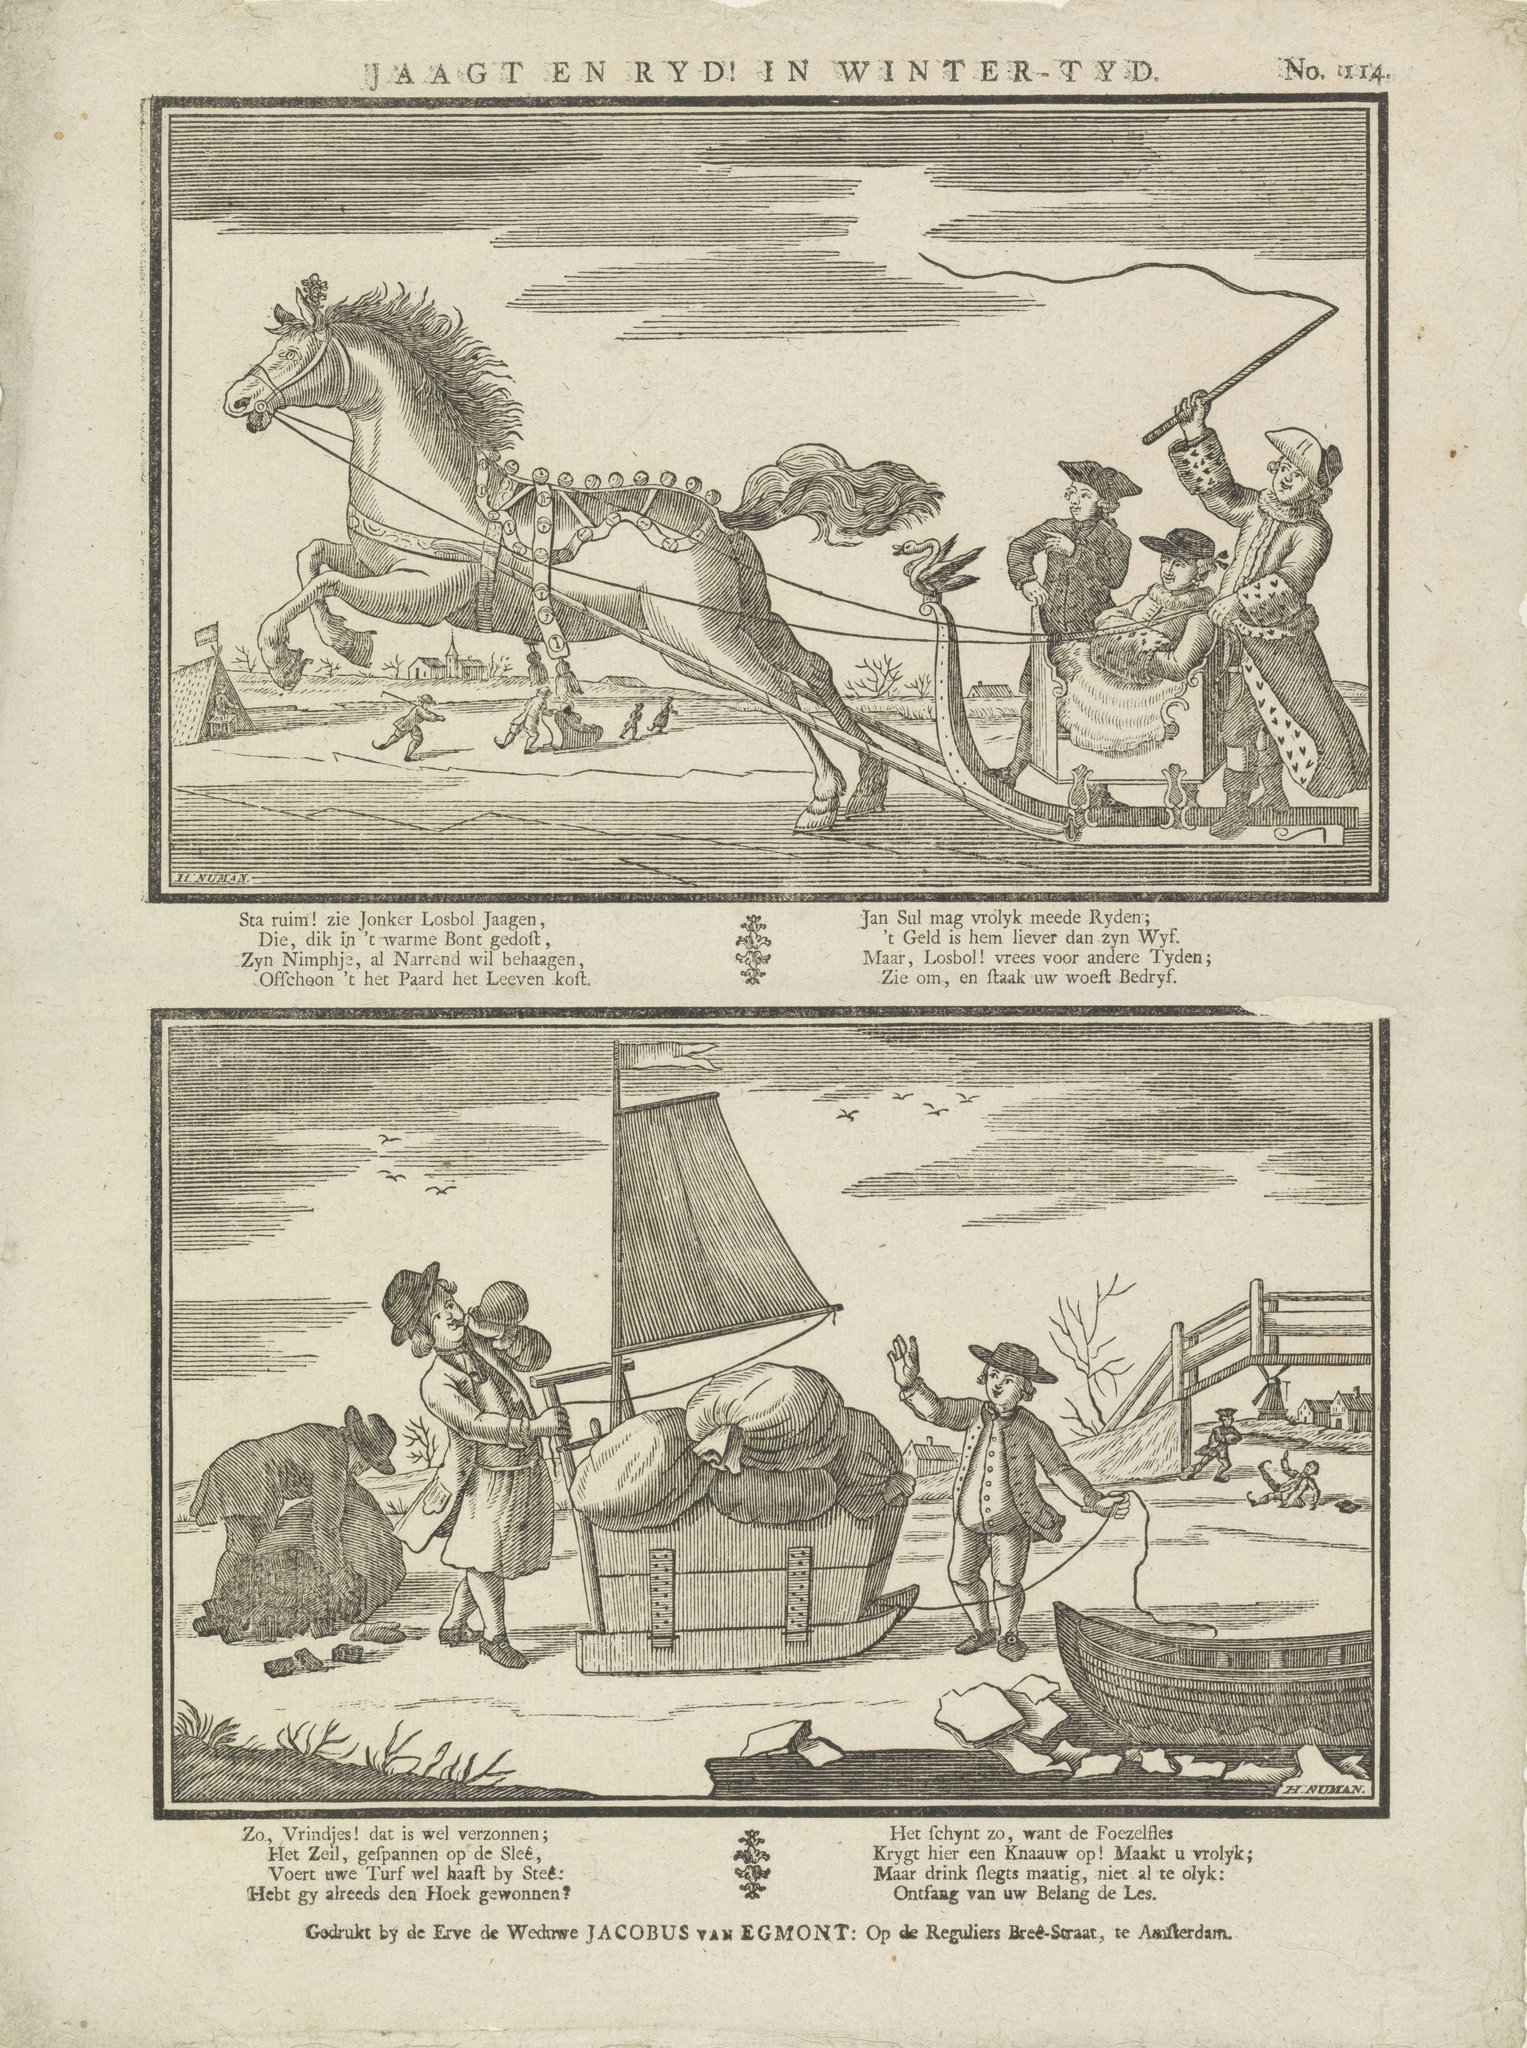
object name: popular print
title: Jaagt en ryd! in winter-tyd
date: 1761-1804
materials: paper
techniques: letterpress printing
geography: amsterdam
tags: children's games and plays (+ accident (in sports, games, etc.))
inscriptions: collector's mark: Lugt 2760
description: Blad met 2 wintertaferelen. Boven: mensen op een door een paard voortgetrokken slee. Onder: jongens die turf bezorgen. Onder elke afbeelding een achtregelig vers in twee kolommen. Genummerd rechtsboven: No. 114.